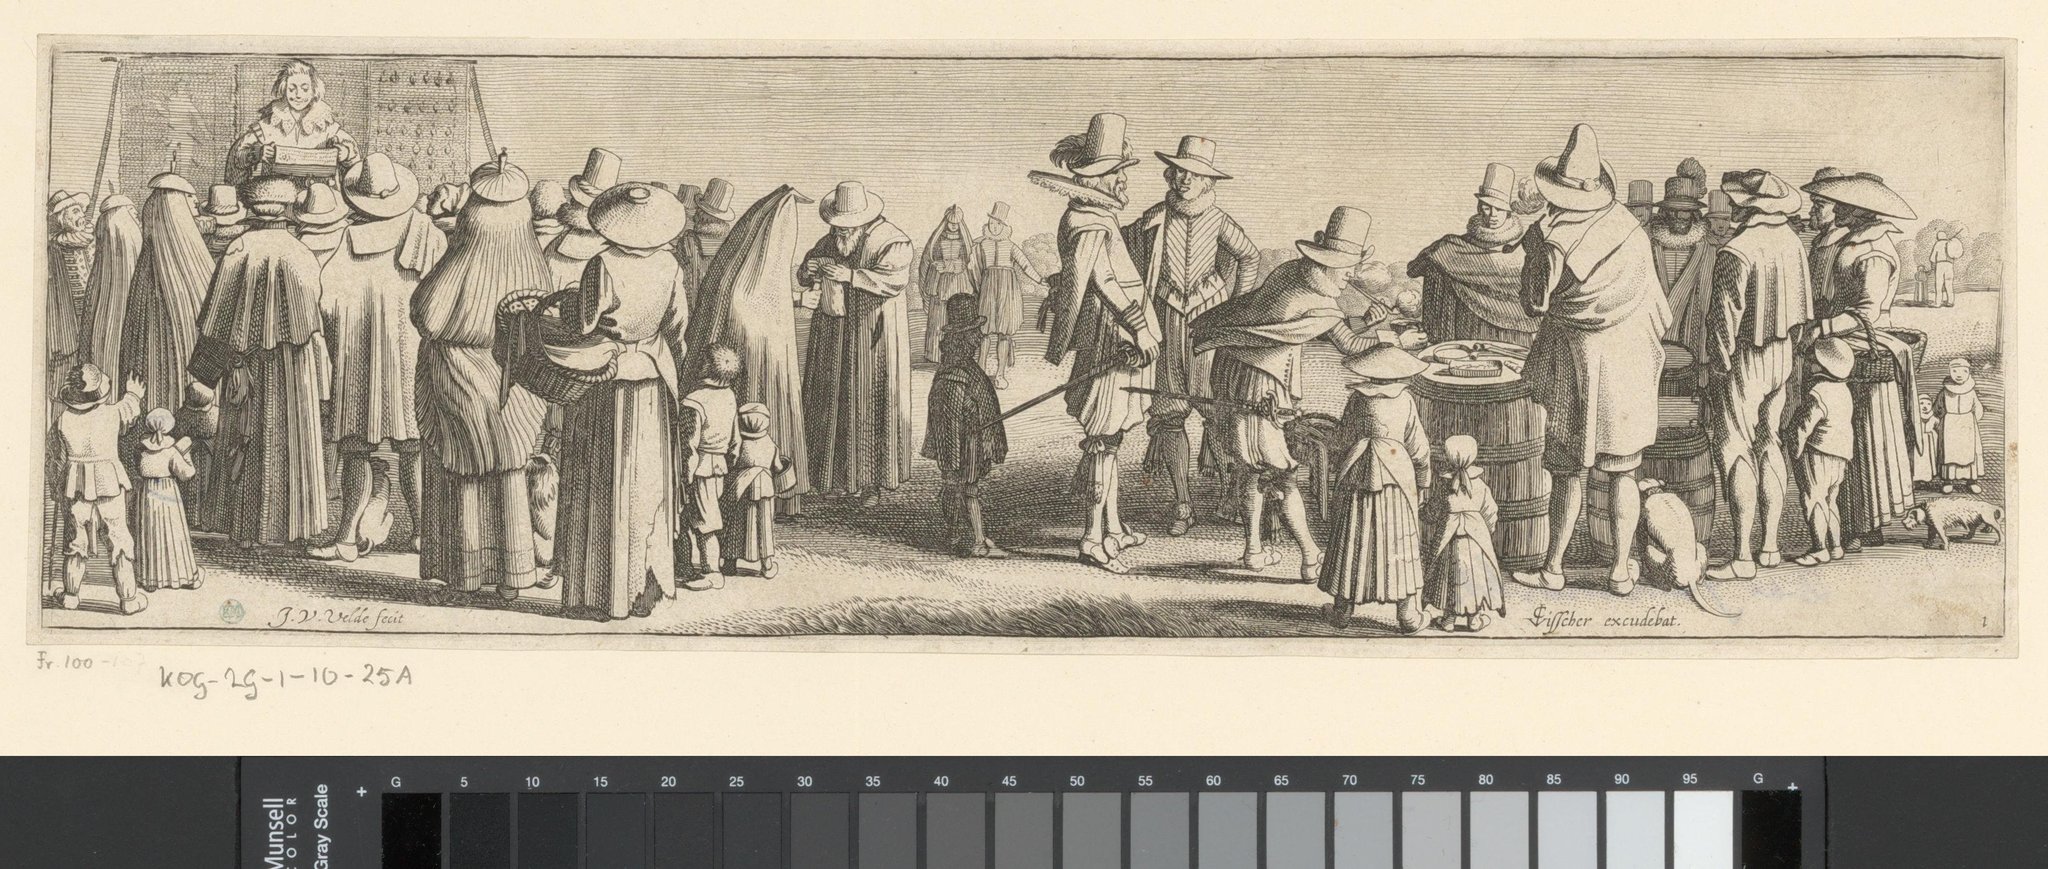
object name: print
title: Markt, serie A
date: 1603-1652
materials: paper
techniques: engraving, etching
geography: amsterdam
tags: cape (huik) (+ women's clothes), quack, charlatan, mountebank, 'saltimbanco', clothes, costume (+ women's clothes), clothes, costume (+ men's clothes), market, person addressing a group, orator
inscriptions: collector's mark: Lugt 5100, collector's mark: Lugt 1641, stamp, collector's mark: Lugt 1934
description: Een markt met links een kwakzalver op een podium, met veel omstanders op de rug gezien. Rechts een andere kwakzalver met instrumenten uitgestald op een ton, waaromheen elegant geklede figuren. Eerste prent van een fries bestaande uit vier prenten, voorstellende een markt. Rechtsonder genummerd: 1. Onderwerpsrubrieken binnen de Atlas Zeden en Gewoonten: Handel, nijverheid en verkeer, Marktwezen, Markttafereelen, Marktfiguren.